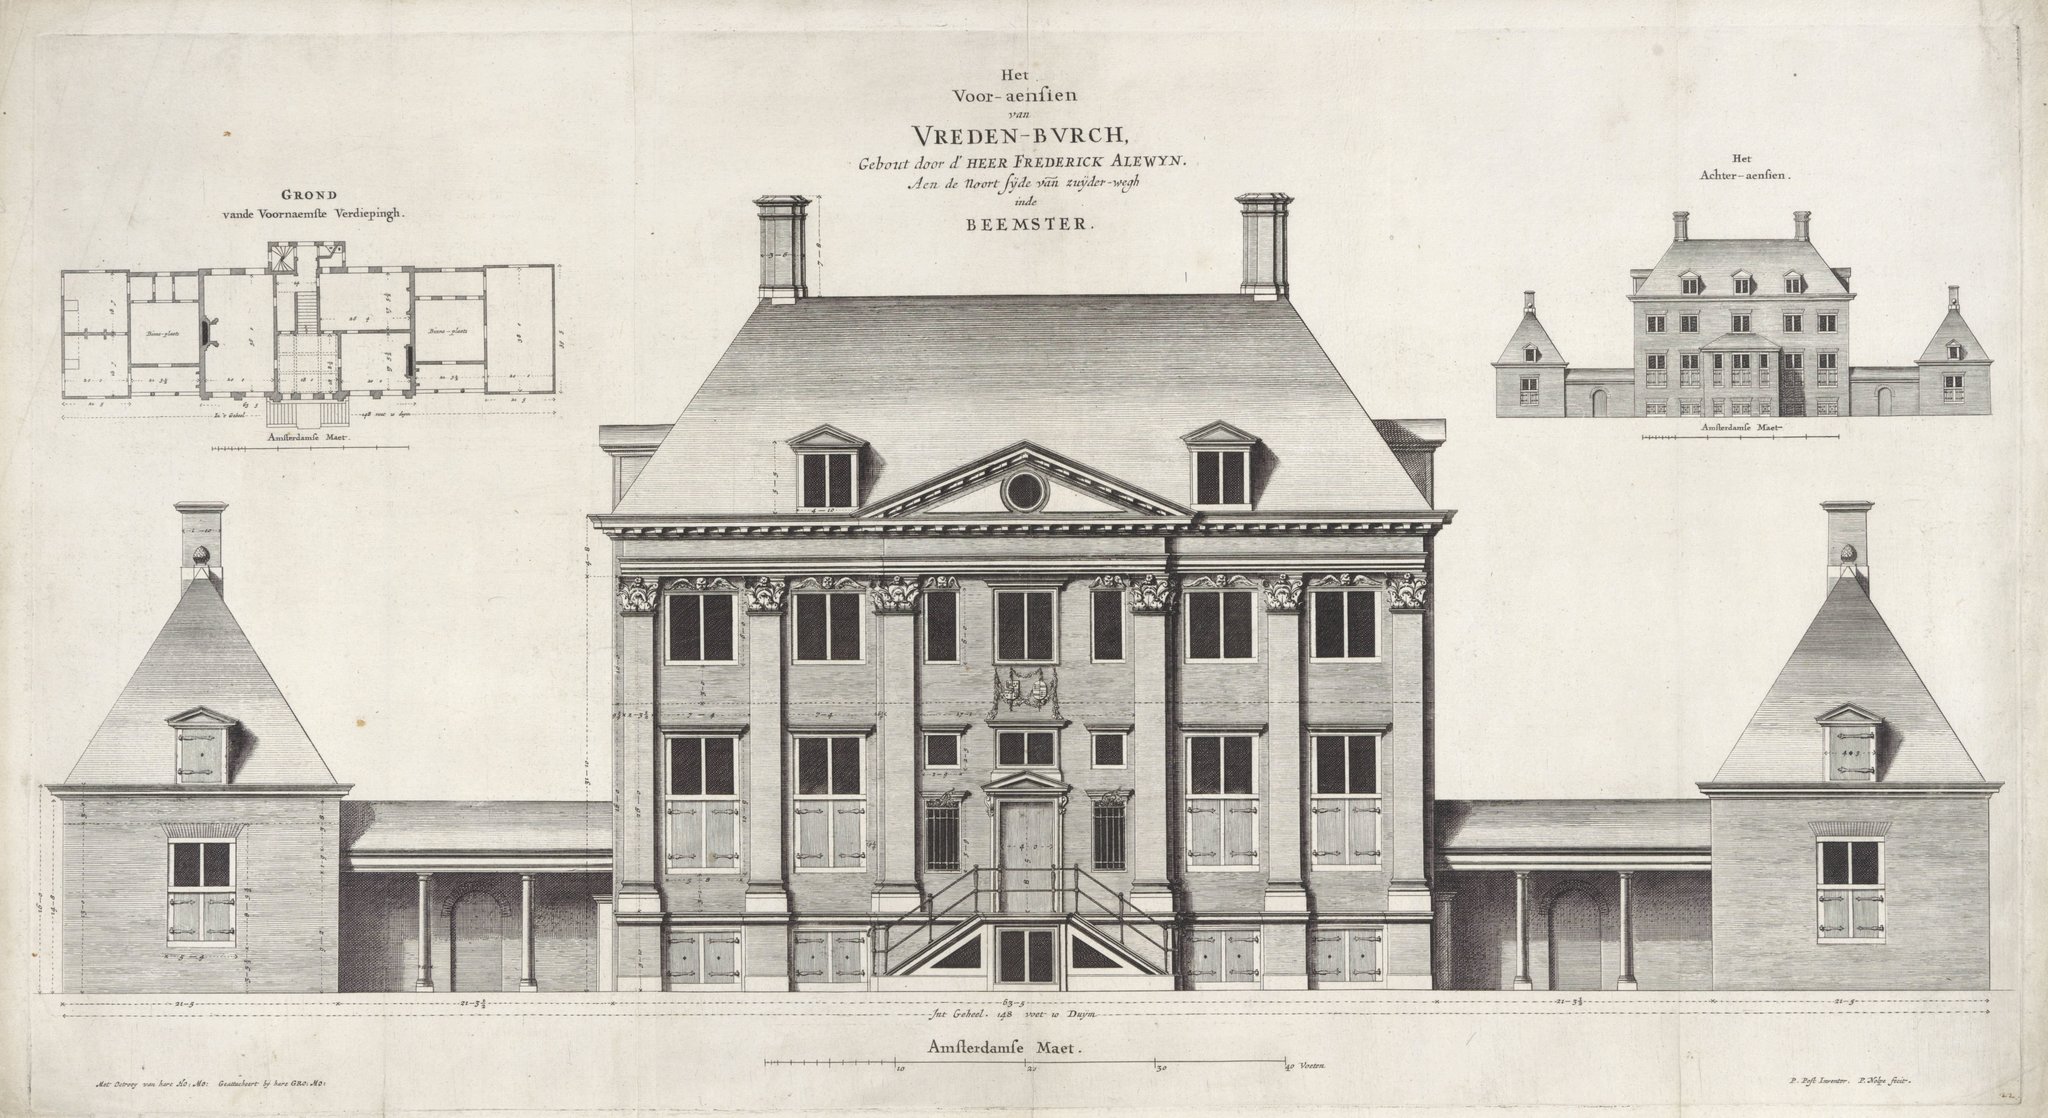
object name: print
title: Huis Vredenburch in de Beemster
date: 1647-1653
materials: paper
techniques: engraving, etching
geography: amsterdam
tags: façade (of house or building), beemster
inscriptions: collector's mark: Lugt 2228, collector's mark: Lugt 2760, collector's mark: Lugt 2166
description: Ontwerp voor en vooraanzicht van buitenplaats Vredenburgh in de Beemster. Linksboven een plattegrond van de voornaamste verdieping. Rechtsboven het achteraanzicht van het landhuis.